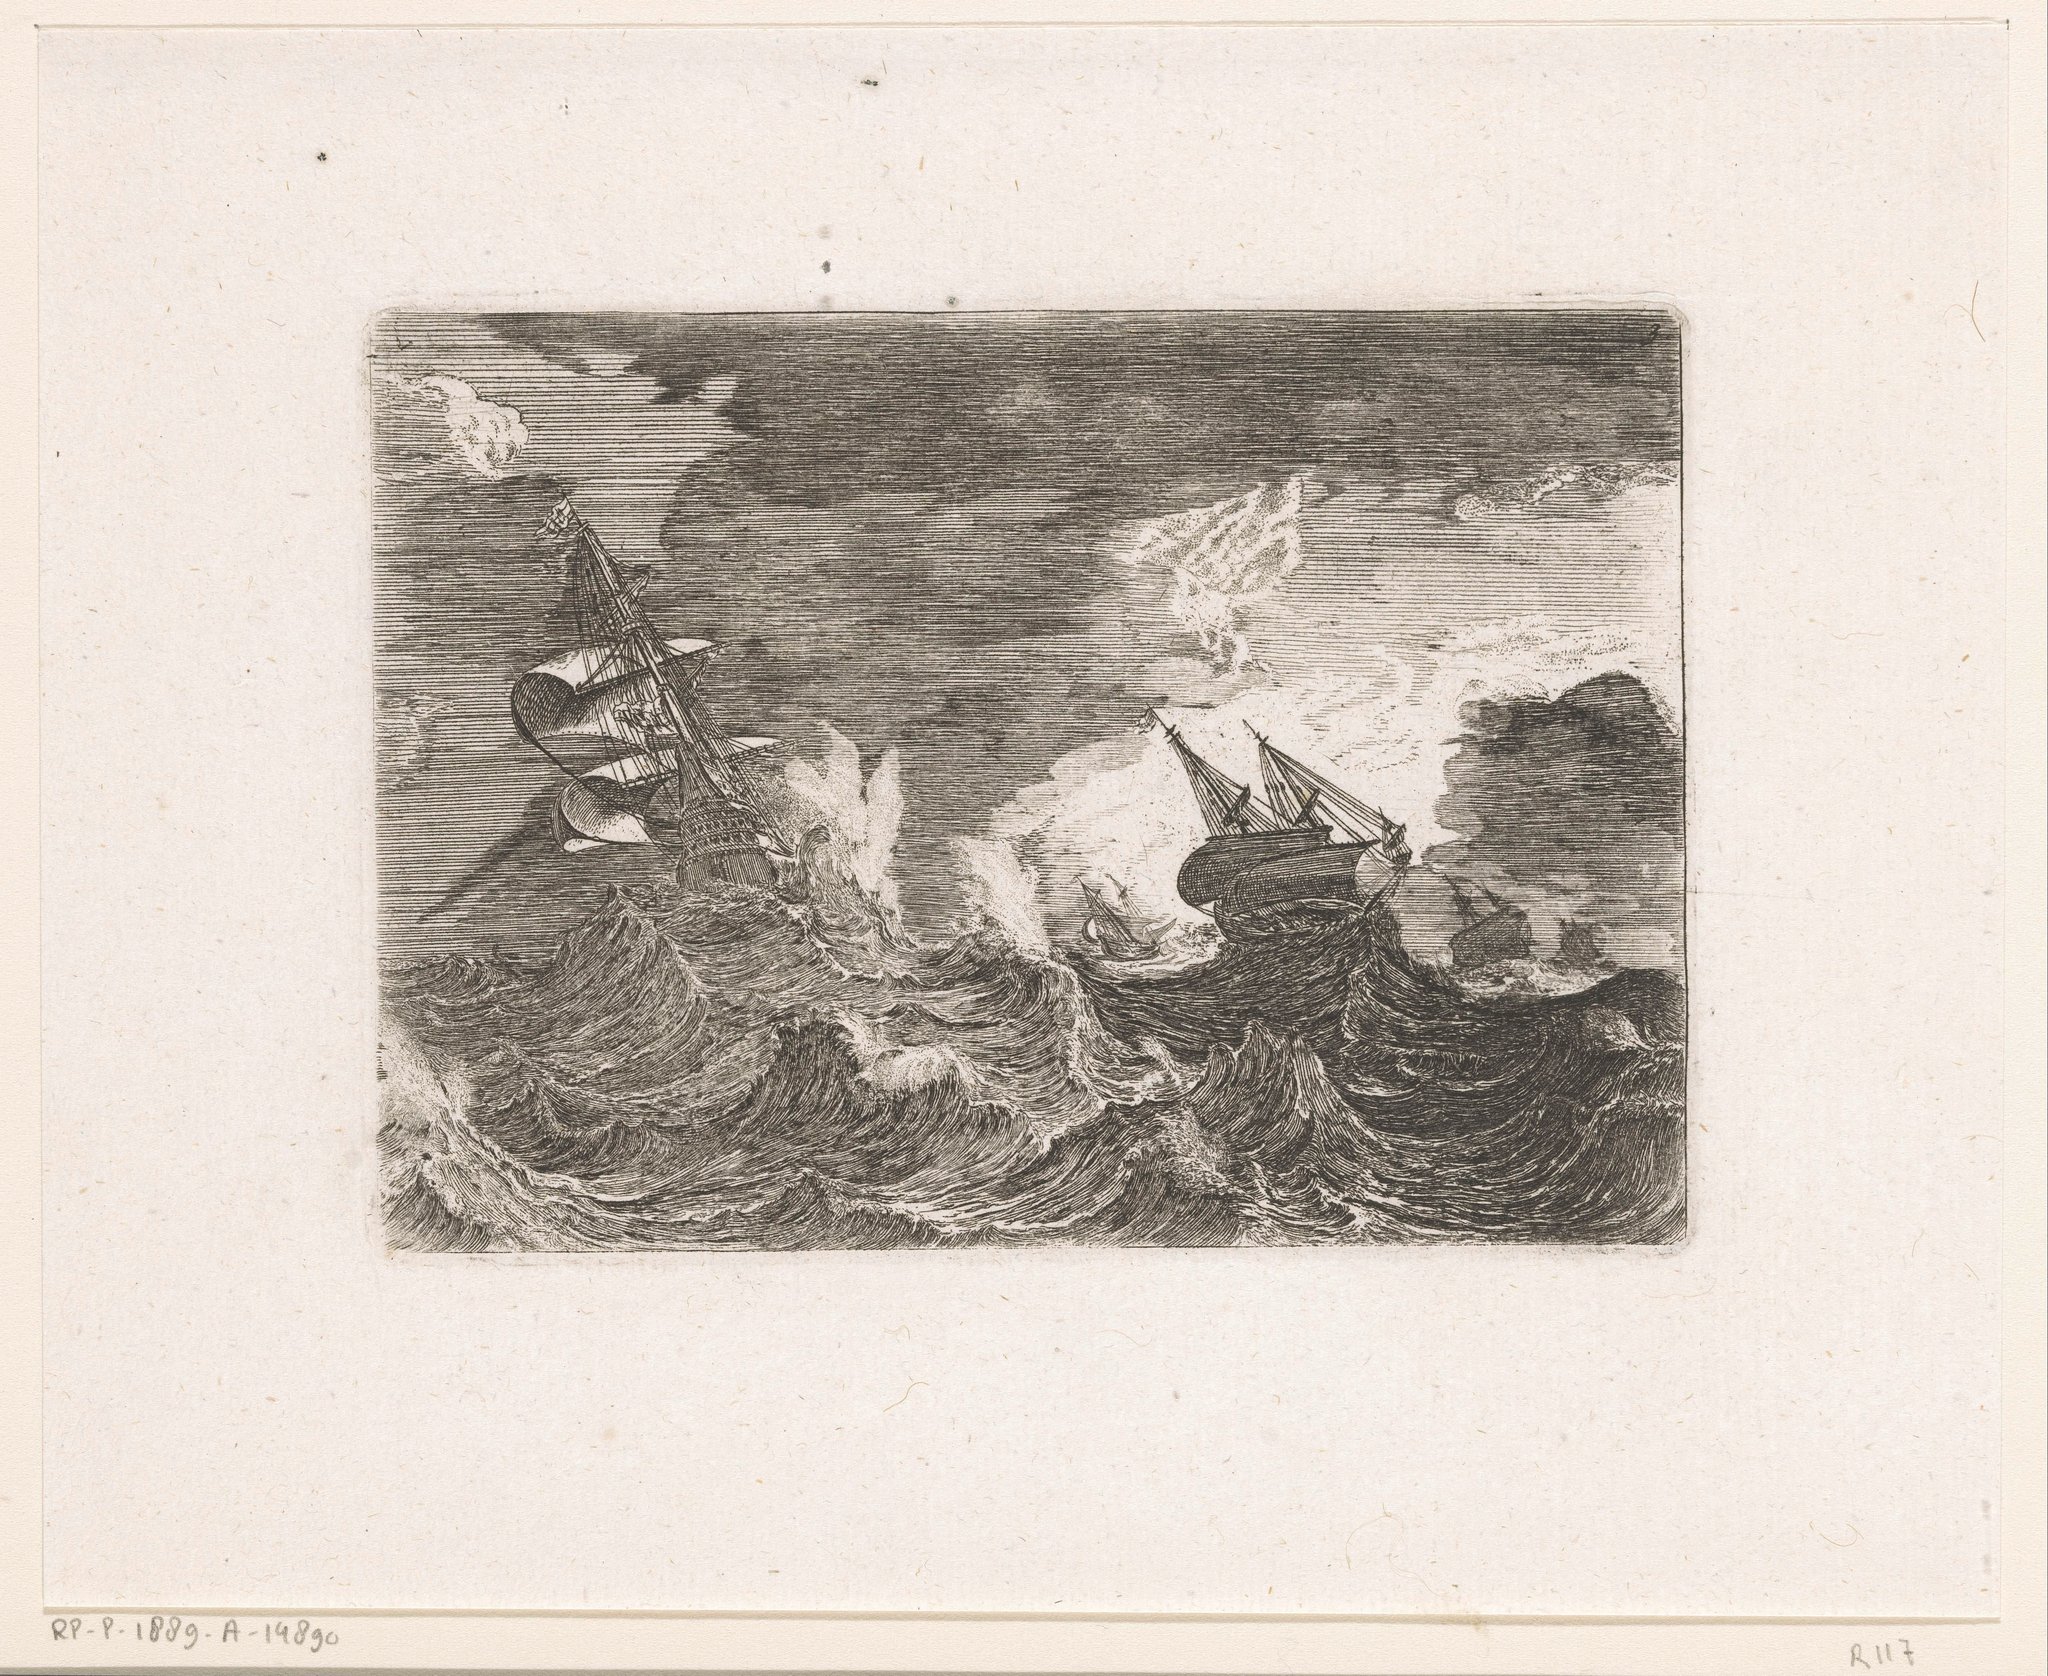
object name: print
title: Vijf zeilschepen op zee tijdens een storm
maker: johann wilhelm baur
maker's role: draughtsman, painter, print maker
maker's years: 1607-1642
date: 1640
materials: paper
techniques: etching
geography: vienna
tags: sailing-ship, sailing-boat, storm at sea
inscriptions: collector's mark: Lugt 2228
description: Derde prent uit de serie 'Schepen in stormachtig weer', bestaand uit vier genummerde prenten. Het betreft hier een latere druk uitgegeven door de erven van Johann Michael Probst te Augsburg.